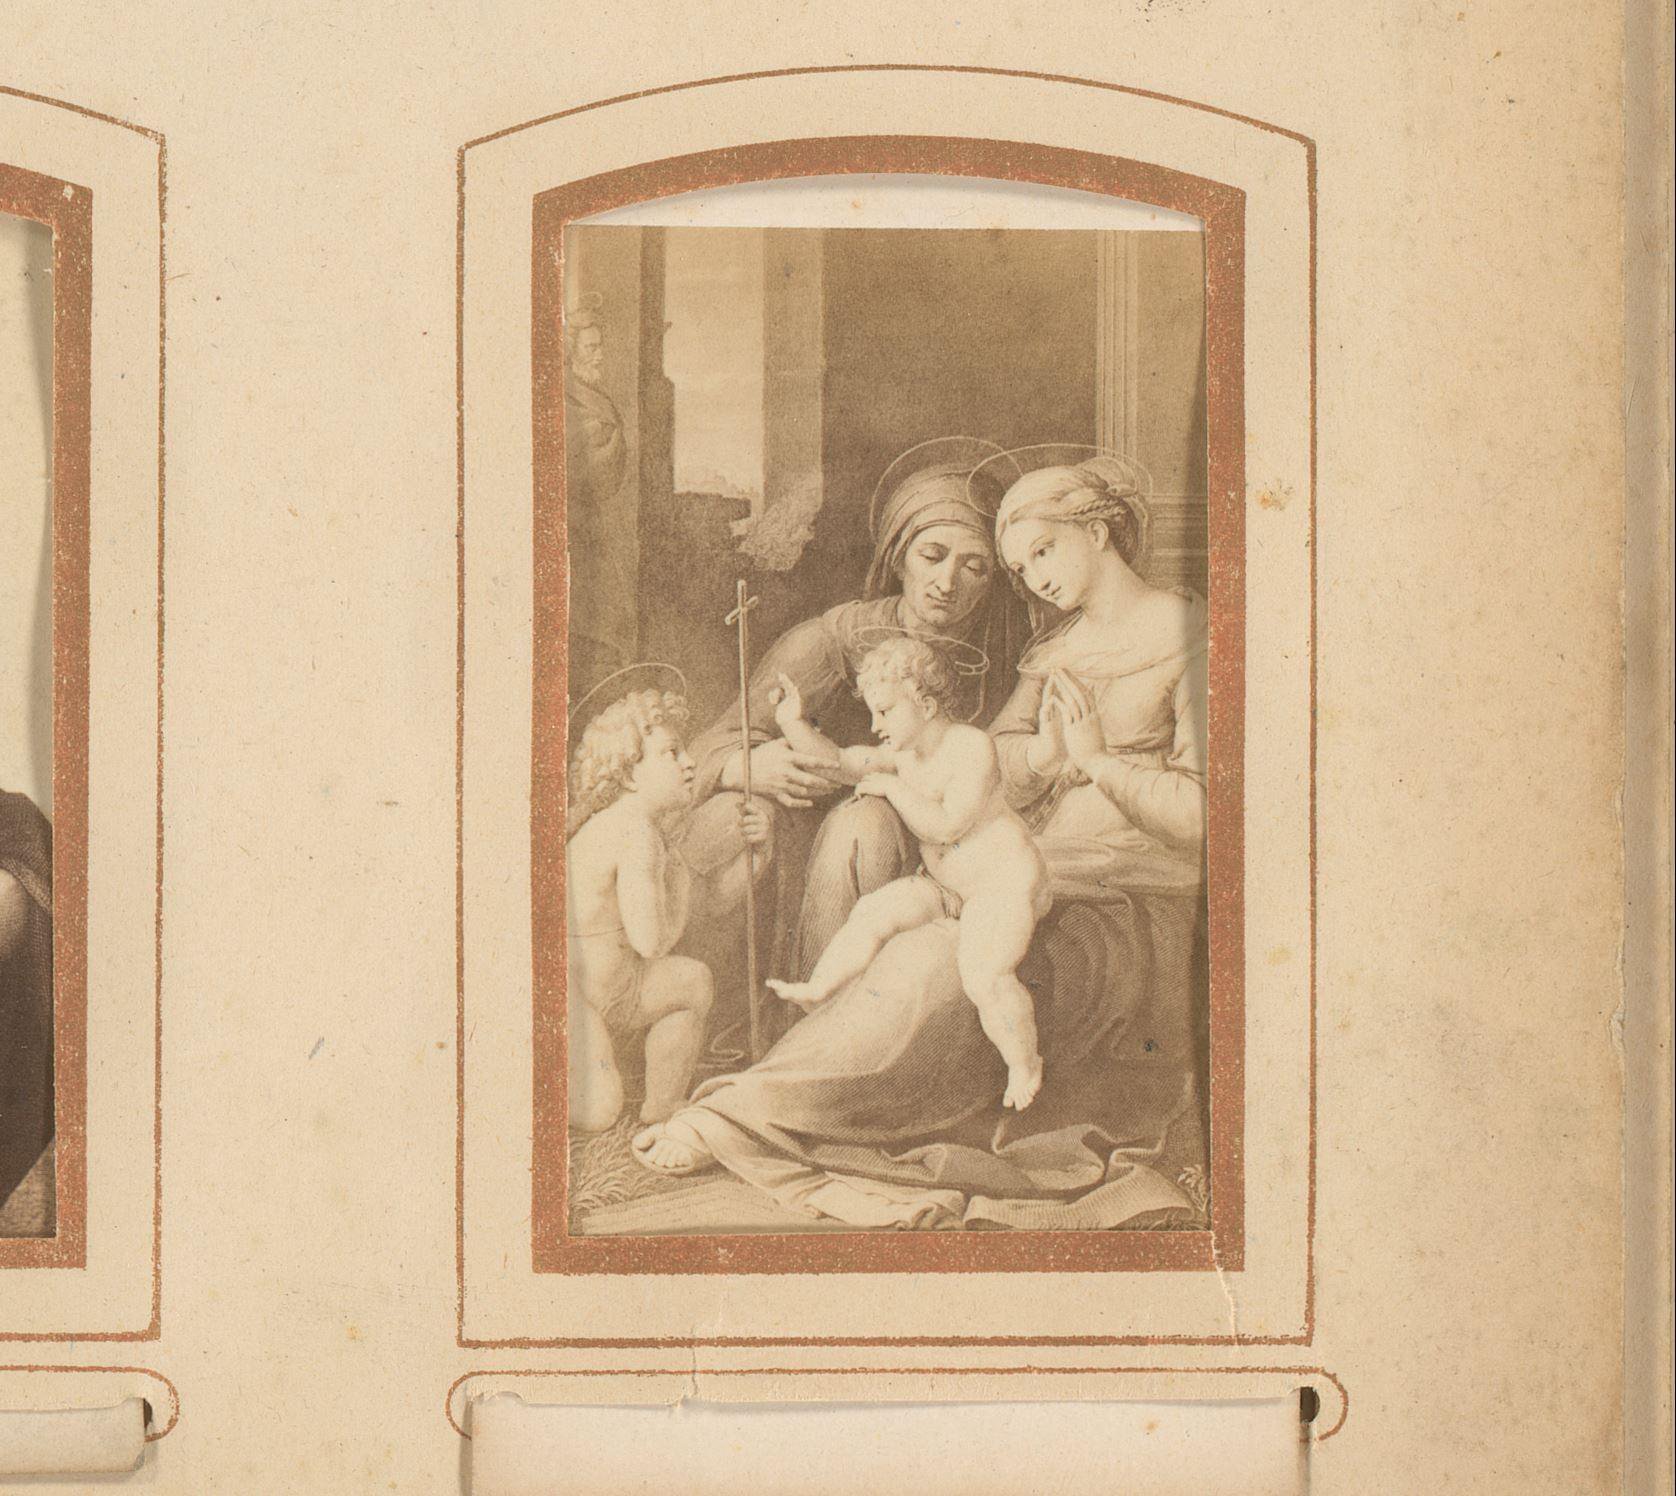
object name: reproduction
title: Fotoreproductie van De heilige familie door Rafaël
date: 1850-1900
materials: cardboard, photographic support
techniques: albumen print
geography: berlin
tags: holy family (alone), 'trinitas terrestris'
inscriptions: inscription: ‘Rafael:/La sainte Famille, dite la bénédiction./ 353./ Die heilige Familie, genannt/ die Benediction./ The holy family, called the/ benediction.’, inscription: ‘Gustav Schauer/ Photographisches Kunst- und Verlags - Institut/ BERLIN/ Grosse Friedrichs - Strasse 188.’